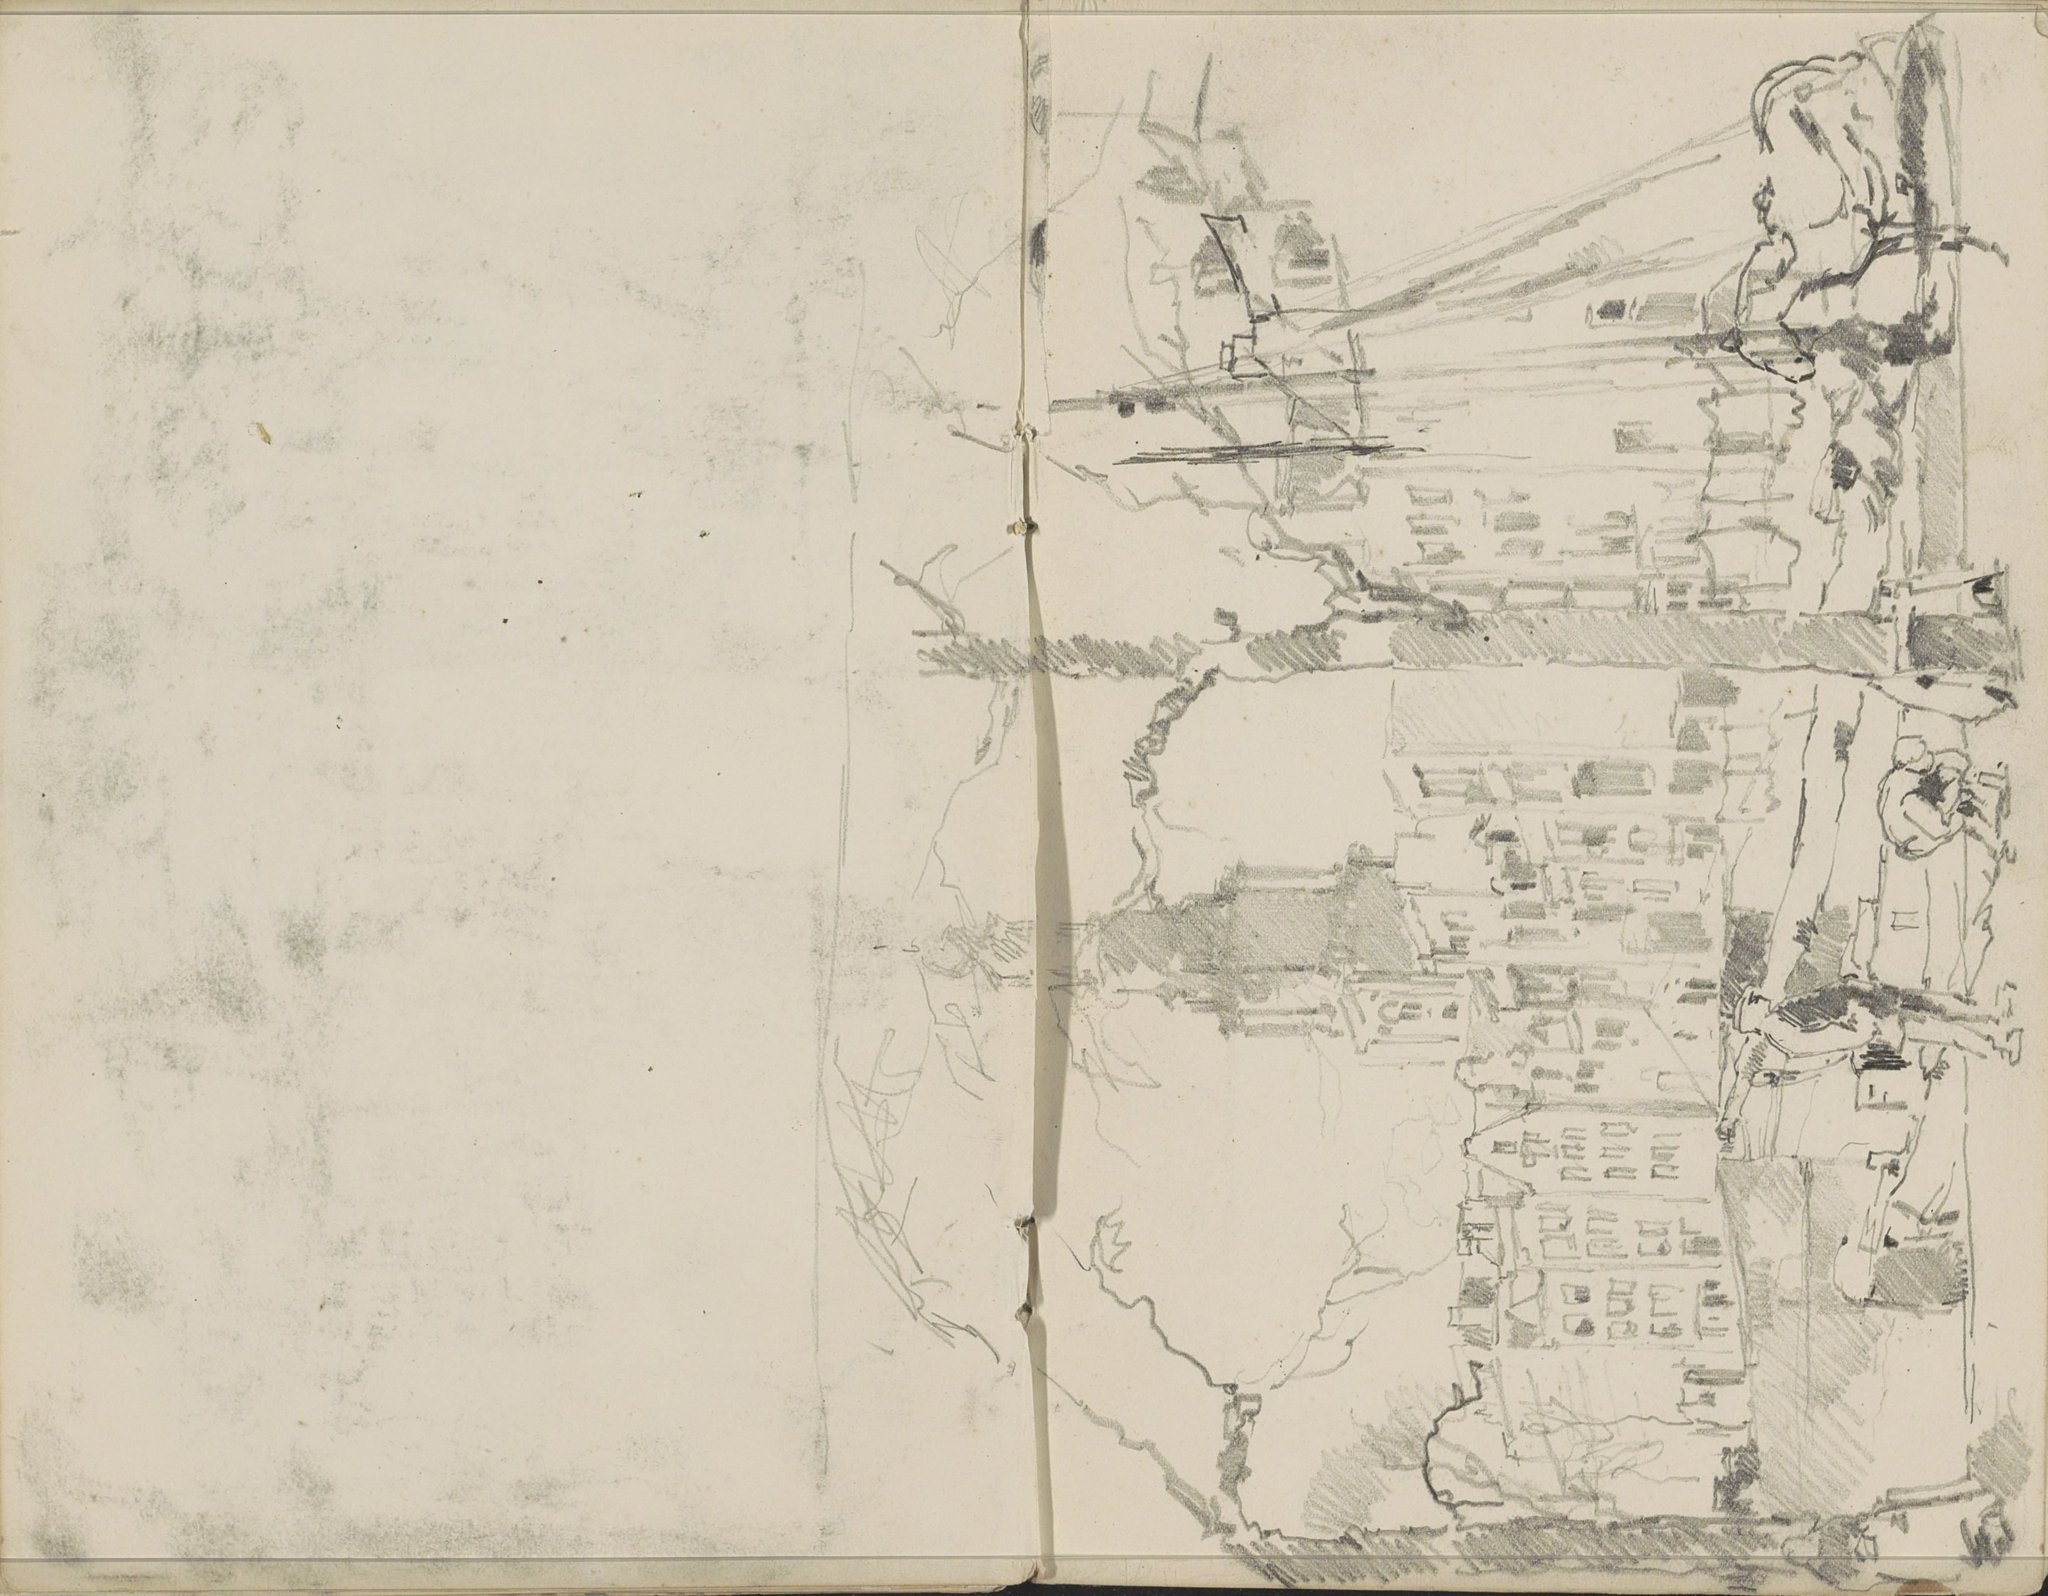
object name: sketchbook leaf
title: Straat langs een gracht te Amsterdam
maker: cornelis vreedenburgh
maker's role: draughtsman, print maker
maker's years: 1880-1946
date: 1890-1946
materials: paper, pencil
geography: amsterdam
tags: city-view, and landscape with man-made constructions, canals, waters (in city), amsterdam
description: Op de achtergrond een kerktoren. Blad 37 verso en 38 recto uit een schetsboek met 45 bladen.